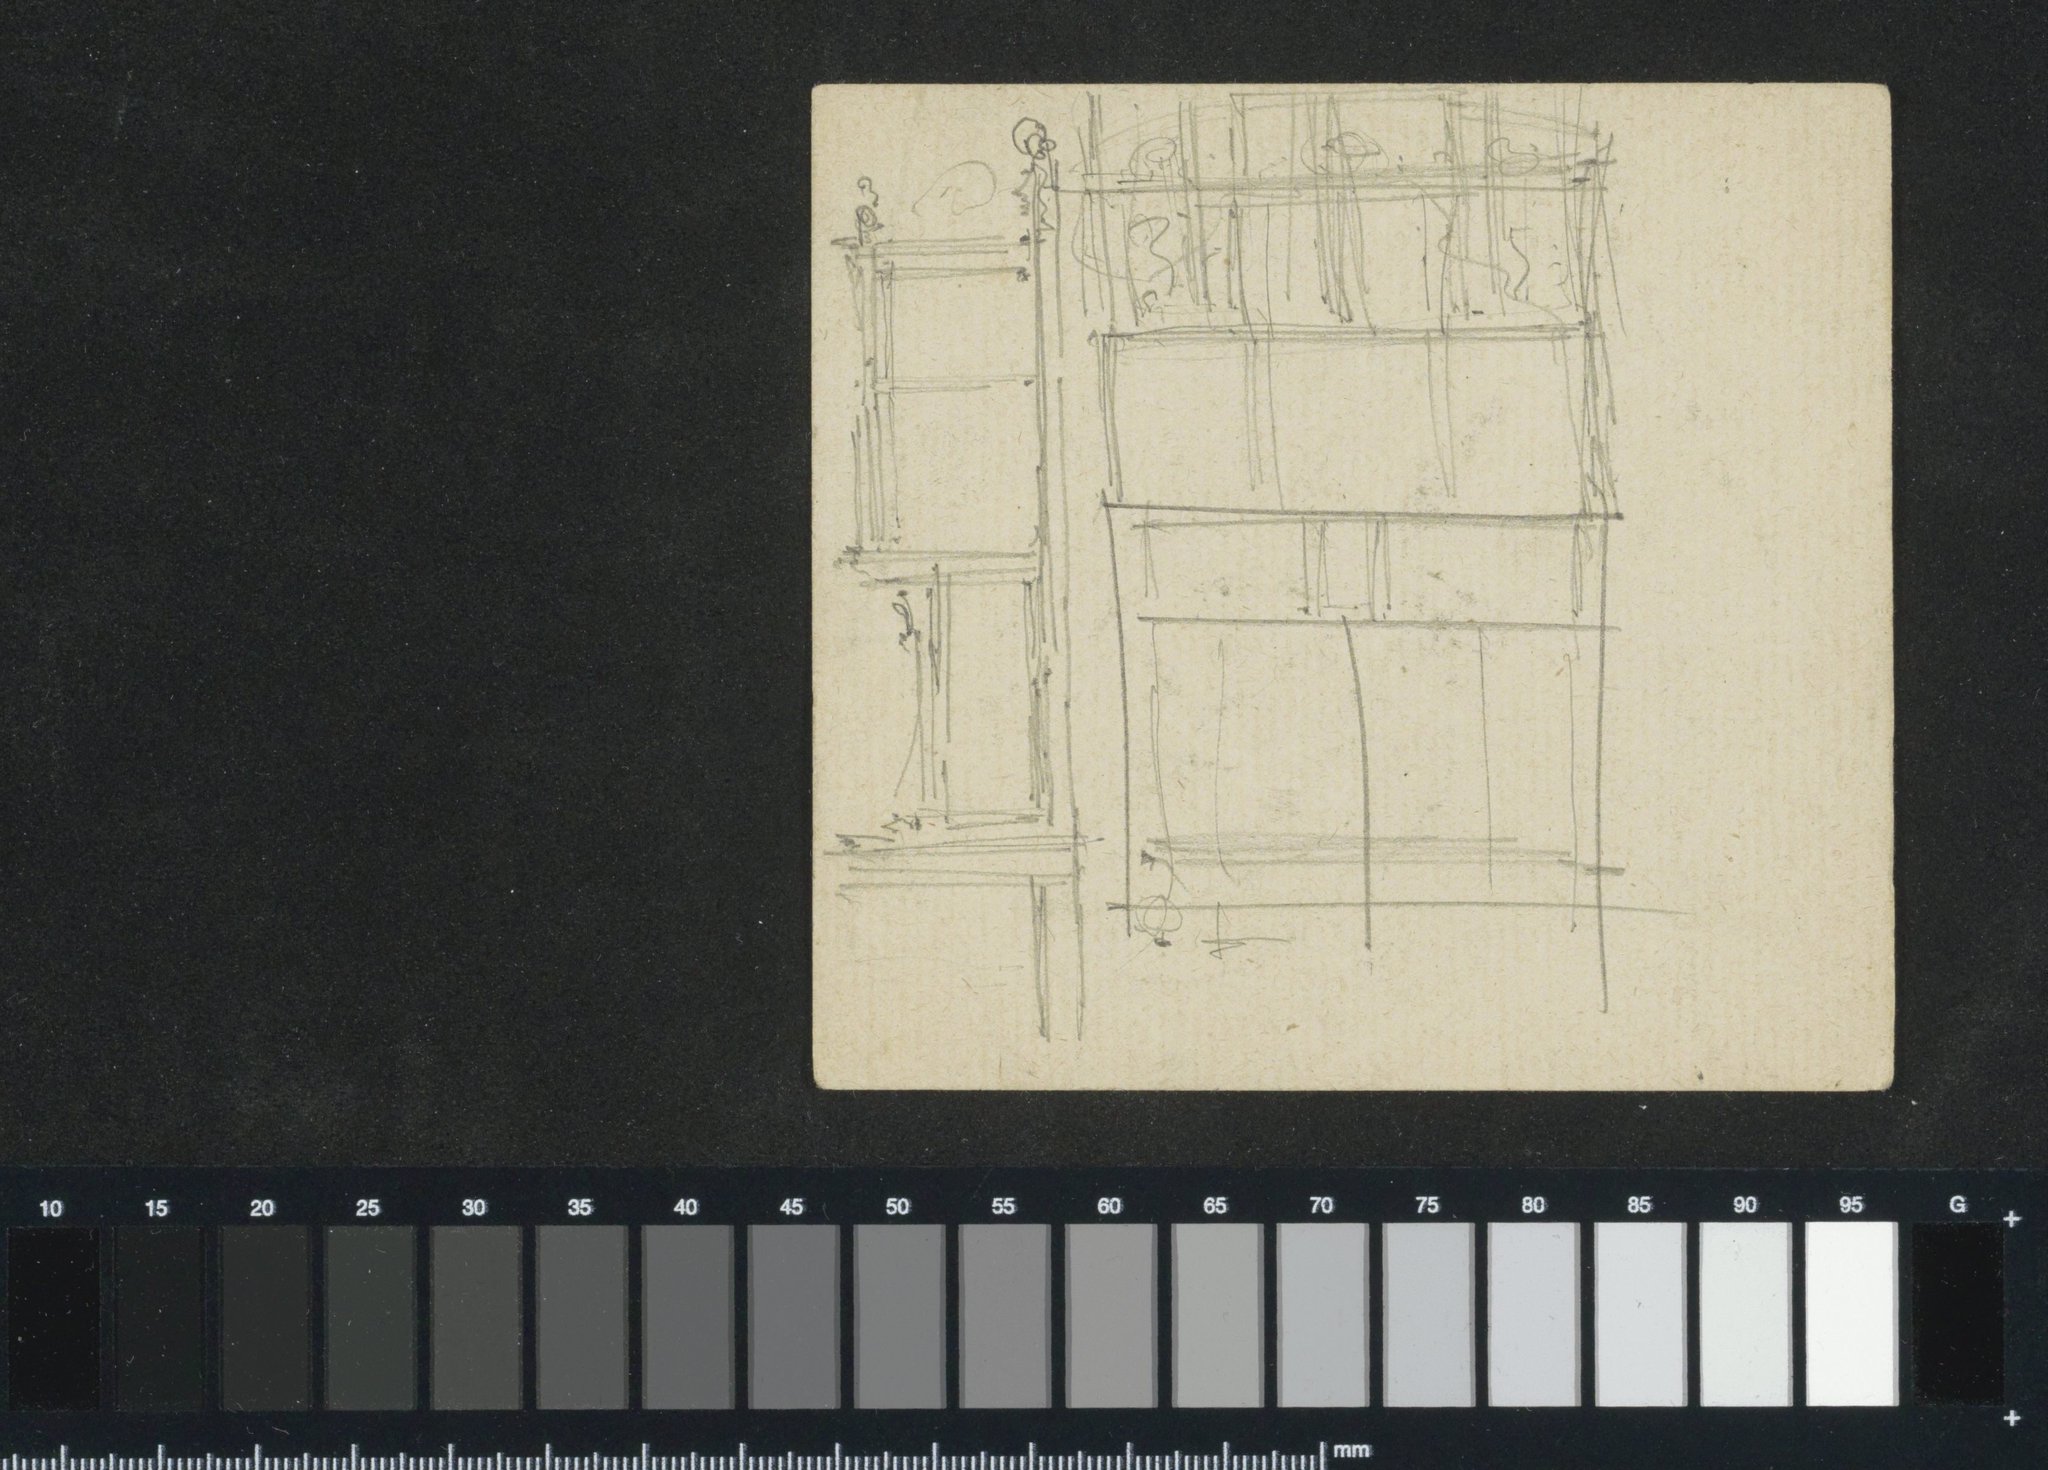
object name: drawing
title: Gevel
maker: gerrit willem dijsselhof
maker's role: designer, draughtsman, print maker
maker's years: 1866-1924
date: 1876-1924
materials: chalk, paper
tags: exterior ~ representation of a building